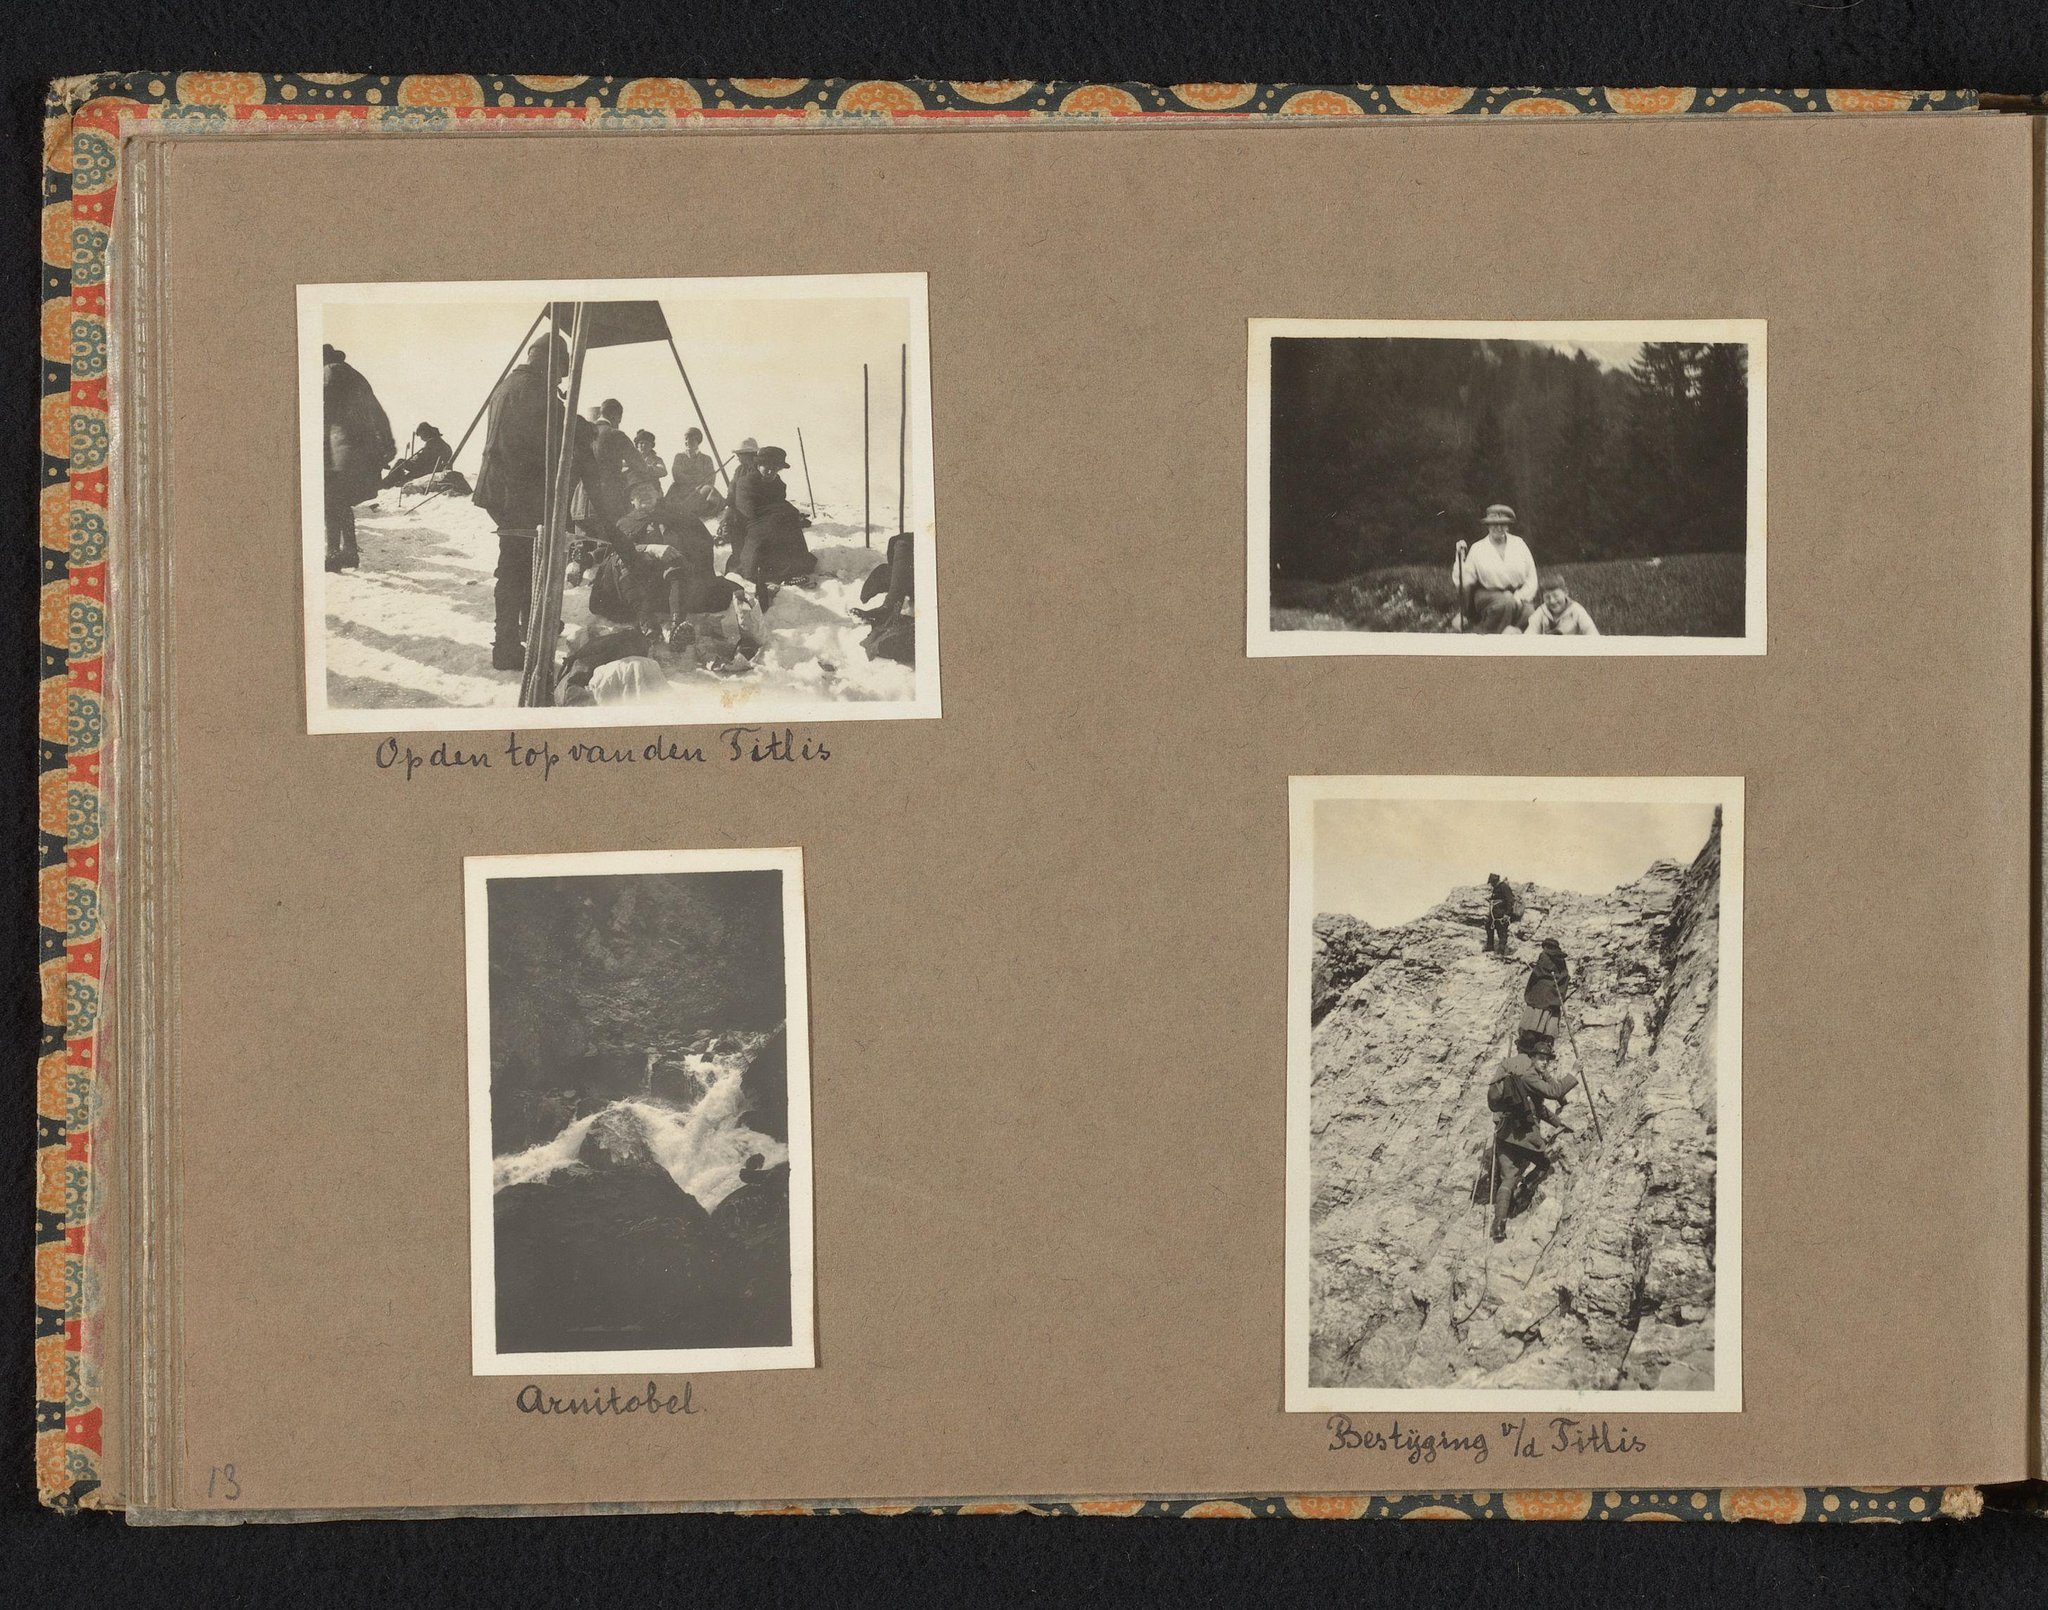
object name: album leaf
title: Vier foto's van familie Van den Berg tijdens wandelingen in de buurt van Engelberg, onder andere de beklimming van de Titlis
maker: hendrik herman van den berg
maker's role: amateurfotograaf, jurist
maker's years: 1875-1944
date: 1920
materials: paper, cardboard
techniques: gelatin silver print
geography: engelberg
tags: the hague, caroline louise van den berg-van den berg, carel frederik van den berg (cay), amsterdam, frank willem van den berg (1912-1998), the family travelling, on holiday, walking, hiking (recreation), historical persons, mountains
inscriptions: caption: ‘Op den top van den Titlis/ Arnitobel./ Bestijging v/d Titlis’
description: Deze foto's maken deel uit van een album.